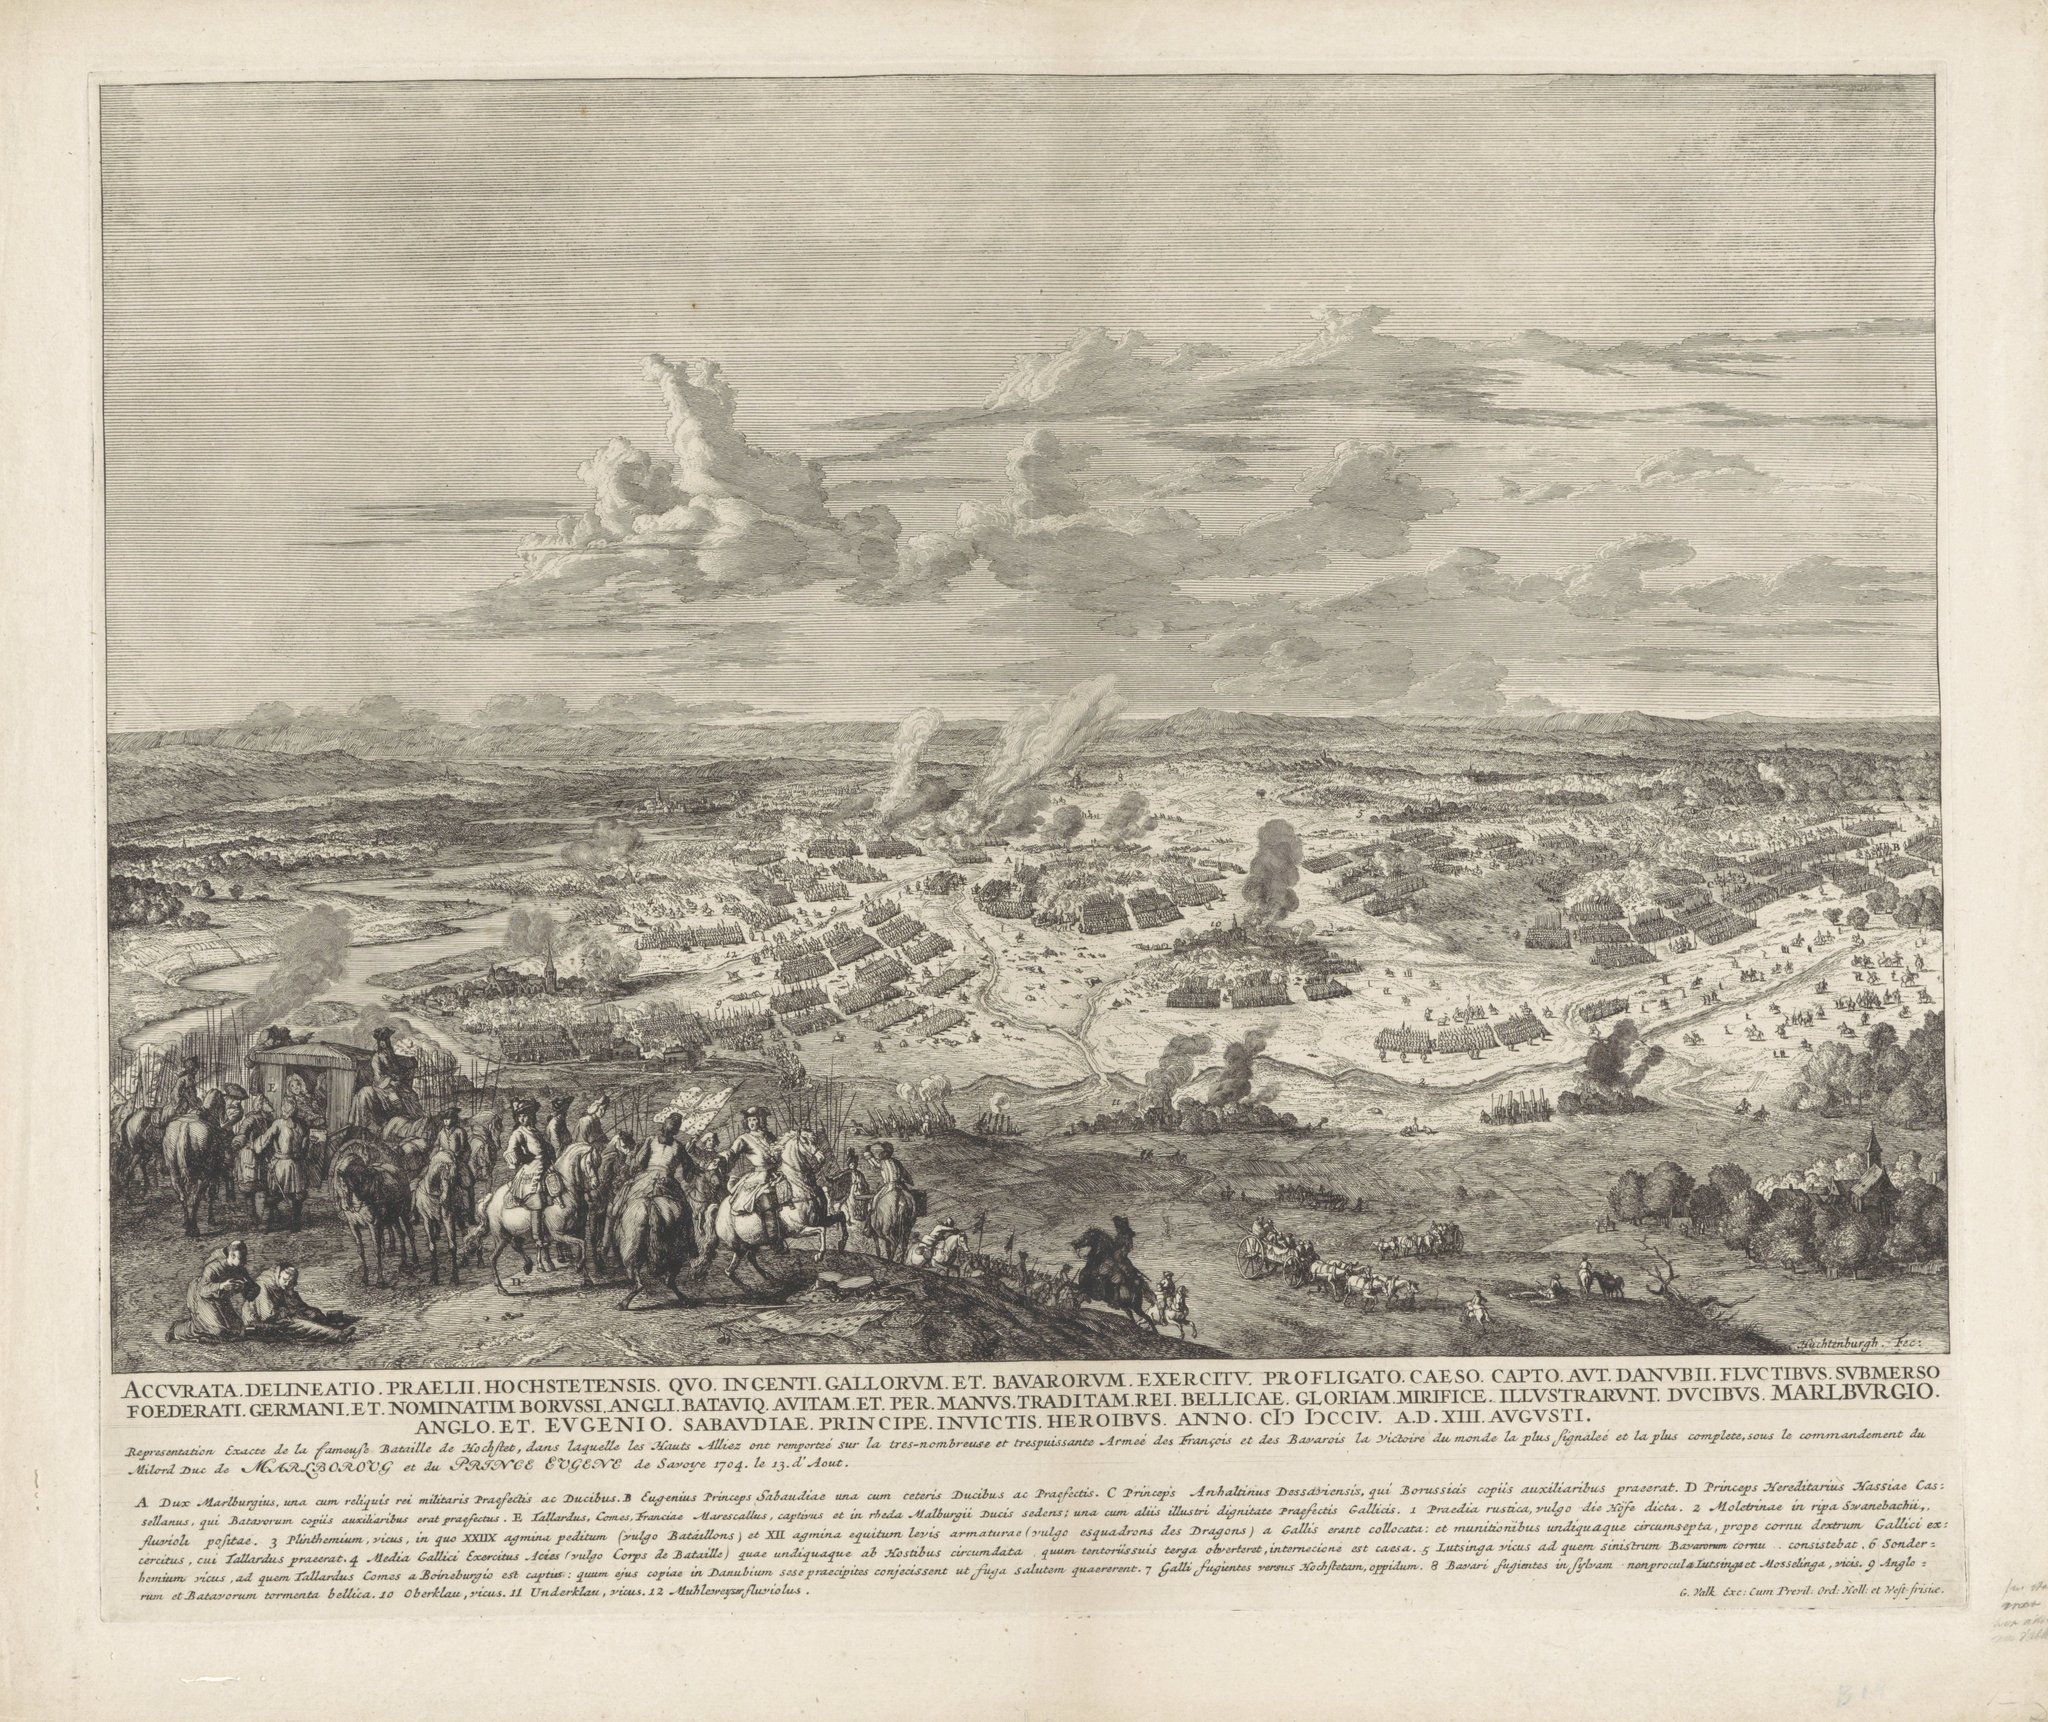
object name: print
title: Slag bij Höchstädt, 1704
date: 1704-1706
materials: paper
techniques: etching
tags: paris, vienna, eugenius van savoye, john churchill (1e hertog van marlborough), battle (+ land forces)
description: Voorstelling van de slag op 13 augustus 1704 bij Höchstädt (slag bij Blenheim) met een overwinning van de Geallieerden op de Fransen. Op de voorgrond prins Eugenius en de hertog van Marlborough, met de duc de Tallard gevangen zittend in de koets van Marlborough. Met onderschrift in het Latijn en Frans.